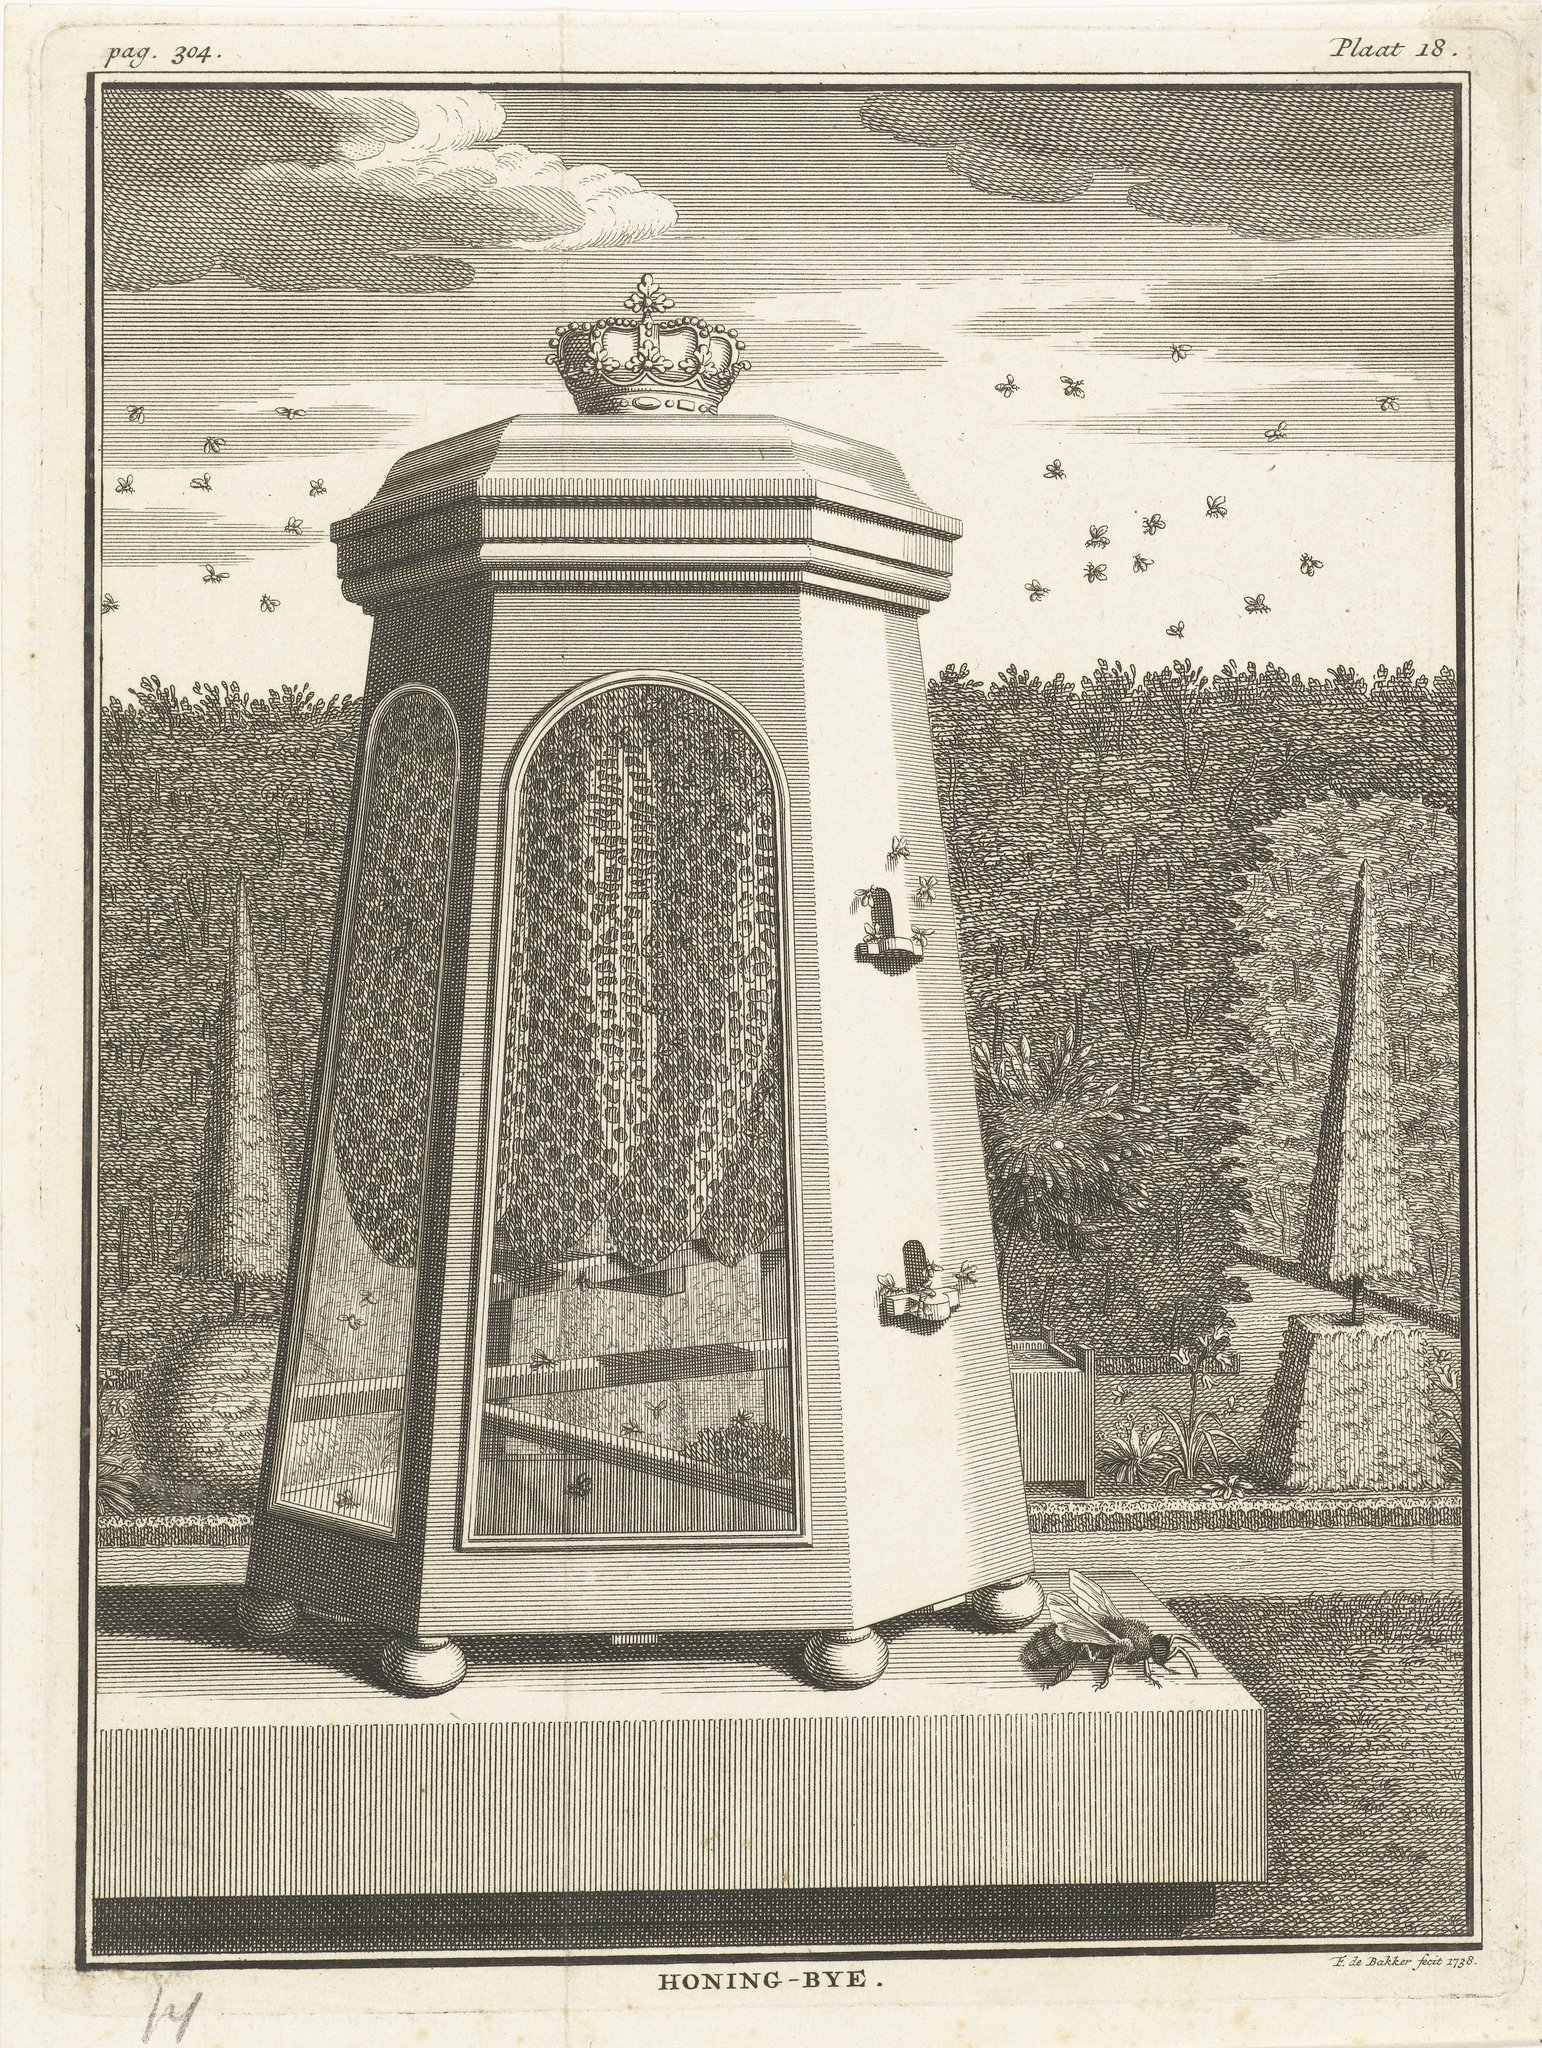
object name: print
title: Honing-Bye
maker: frans de bakker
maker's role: print maker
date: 1738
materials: paper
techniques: etching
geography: amsterdam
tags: insects: bee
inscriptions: collector's mark: Lugt 2228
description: Bijenkast met drie honingraten in een parkachtig landschap. Op de voorgrond is een bij uitvergroot.